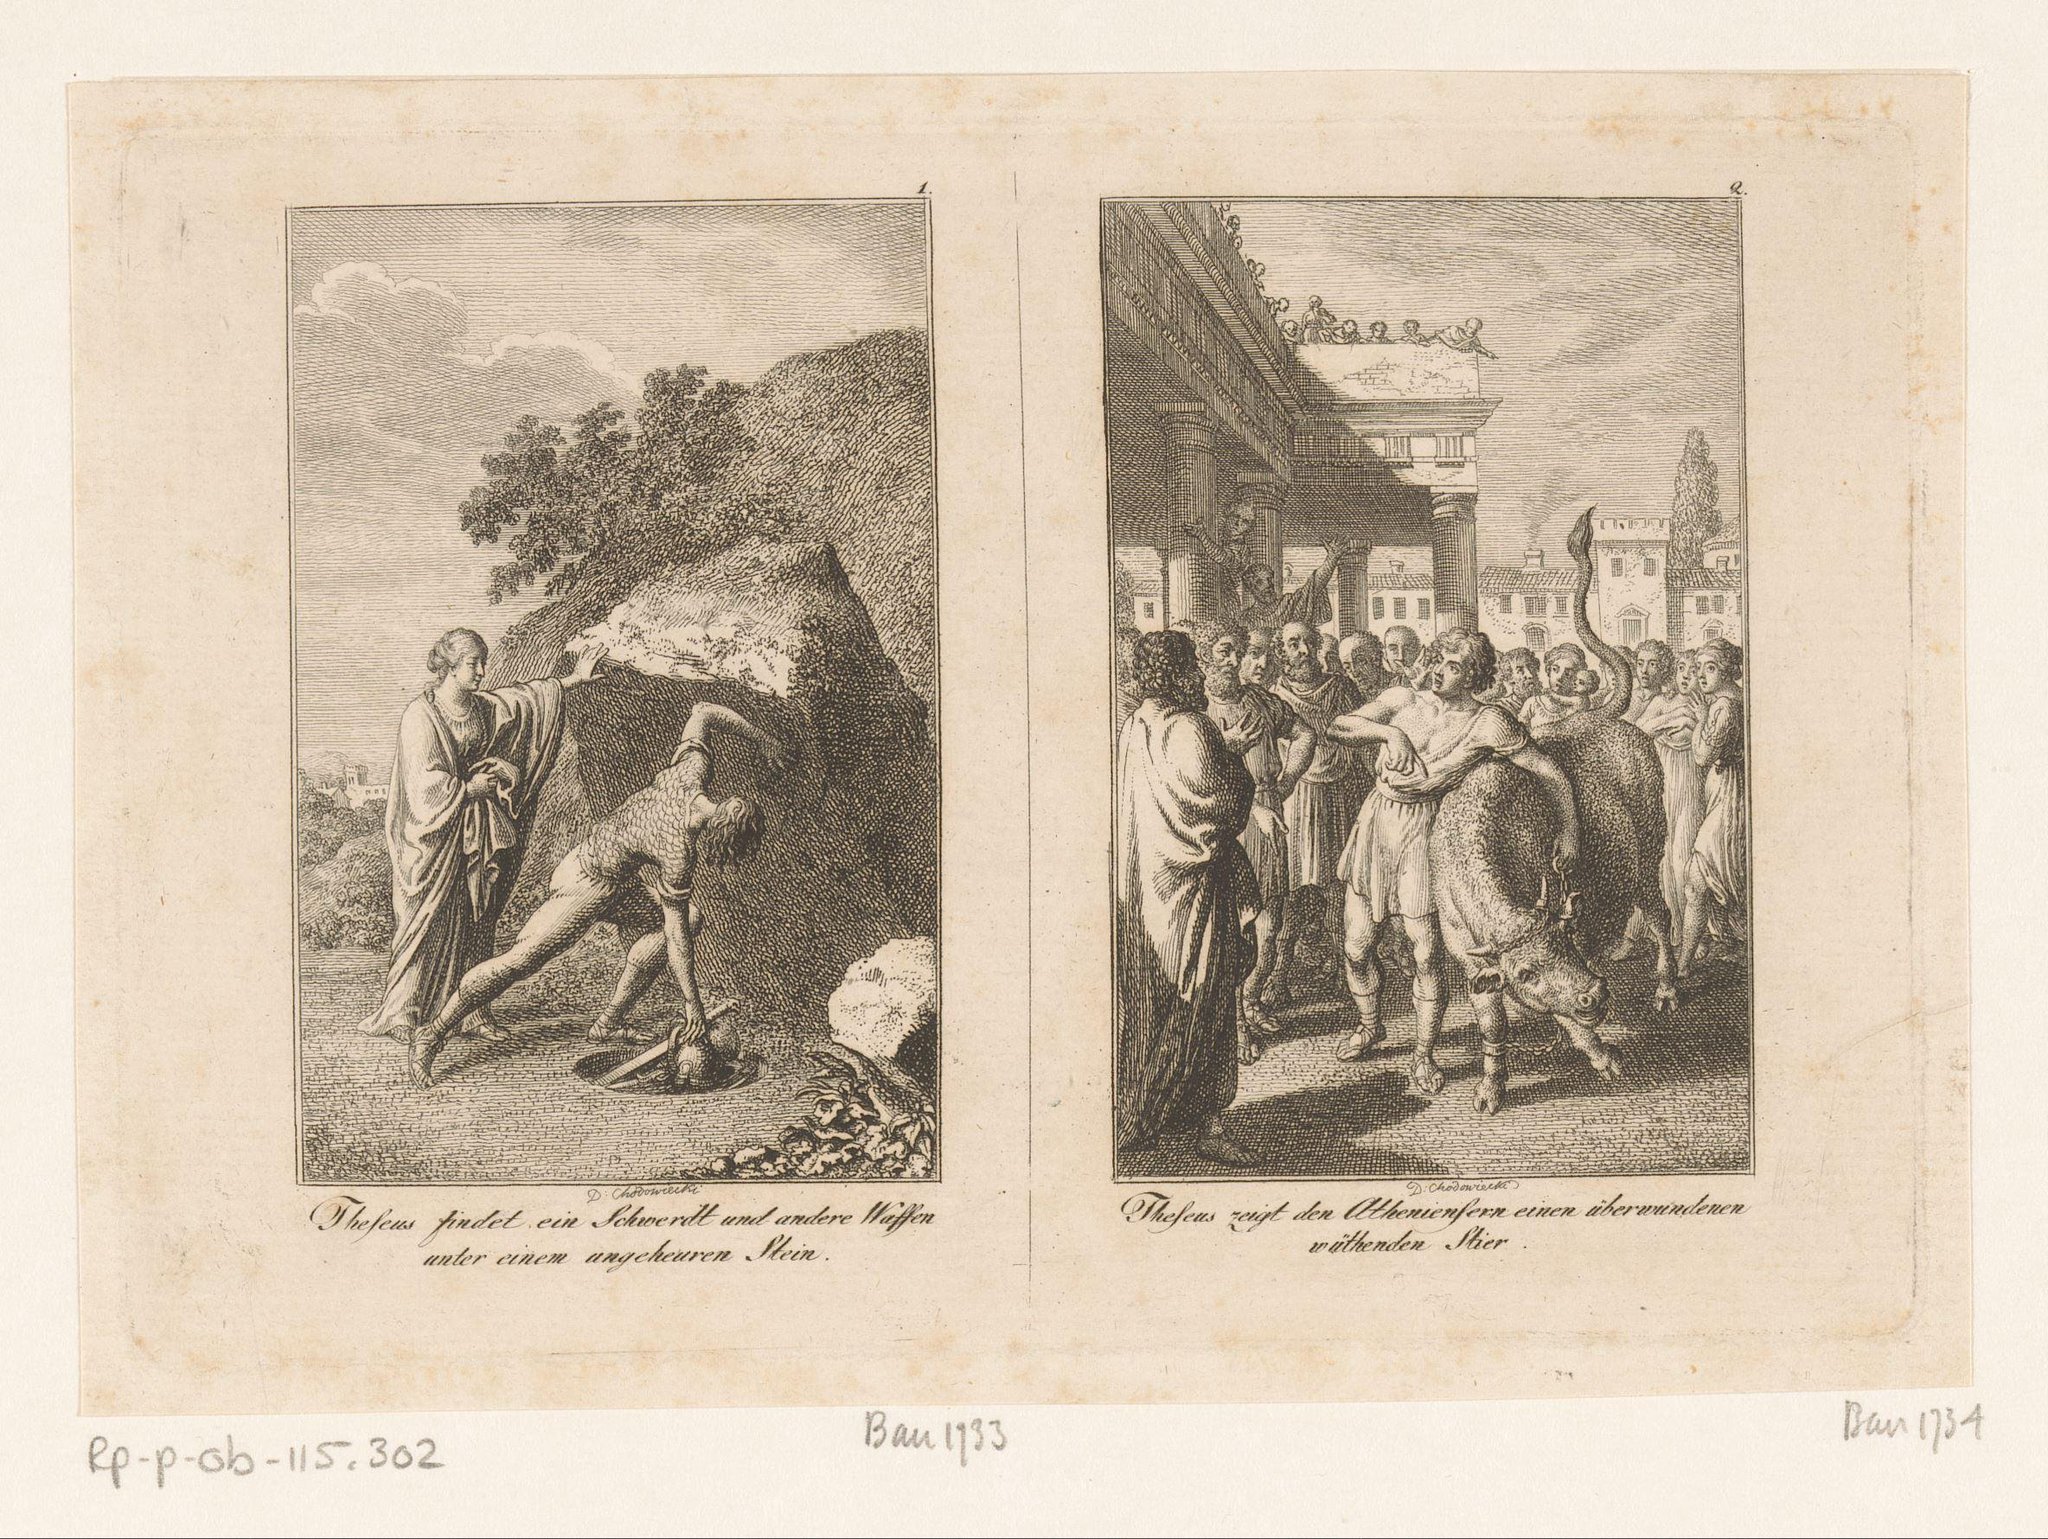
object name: print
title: Twee voorstellingen uit het leven van Theseus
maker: daniel nikolaus chodowiecki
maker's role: draughtsman, print maker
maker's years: 1726-1801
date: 1794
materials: paper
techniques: etching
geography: berlin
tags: theseus takes the sword and the sandals of his father aegeus from under the rock; usually in the presence of his mother aethra, theseus captures the bull of marathon, (story of) theseus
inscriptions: collector's mark: Lugt 2228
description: Prenten gebruikt voor: Becker, Wilhelm Gottlieb. Taschenbuch und Almanach zum geselligen Vernügen von W. G. Becker für 1795. Leipzig: Voss und Companie, s.a.